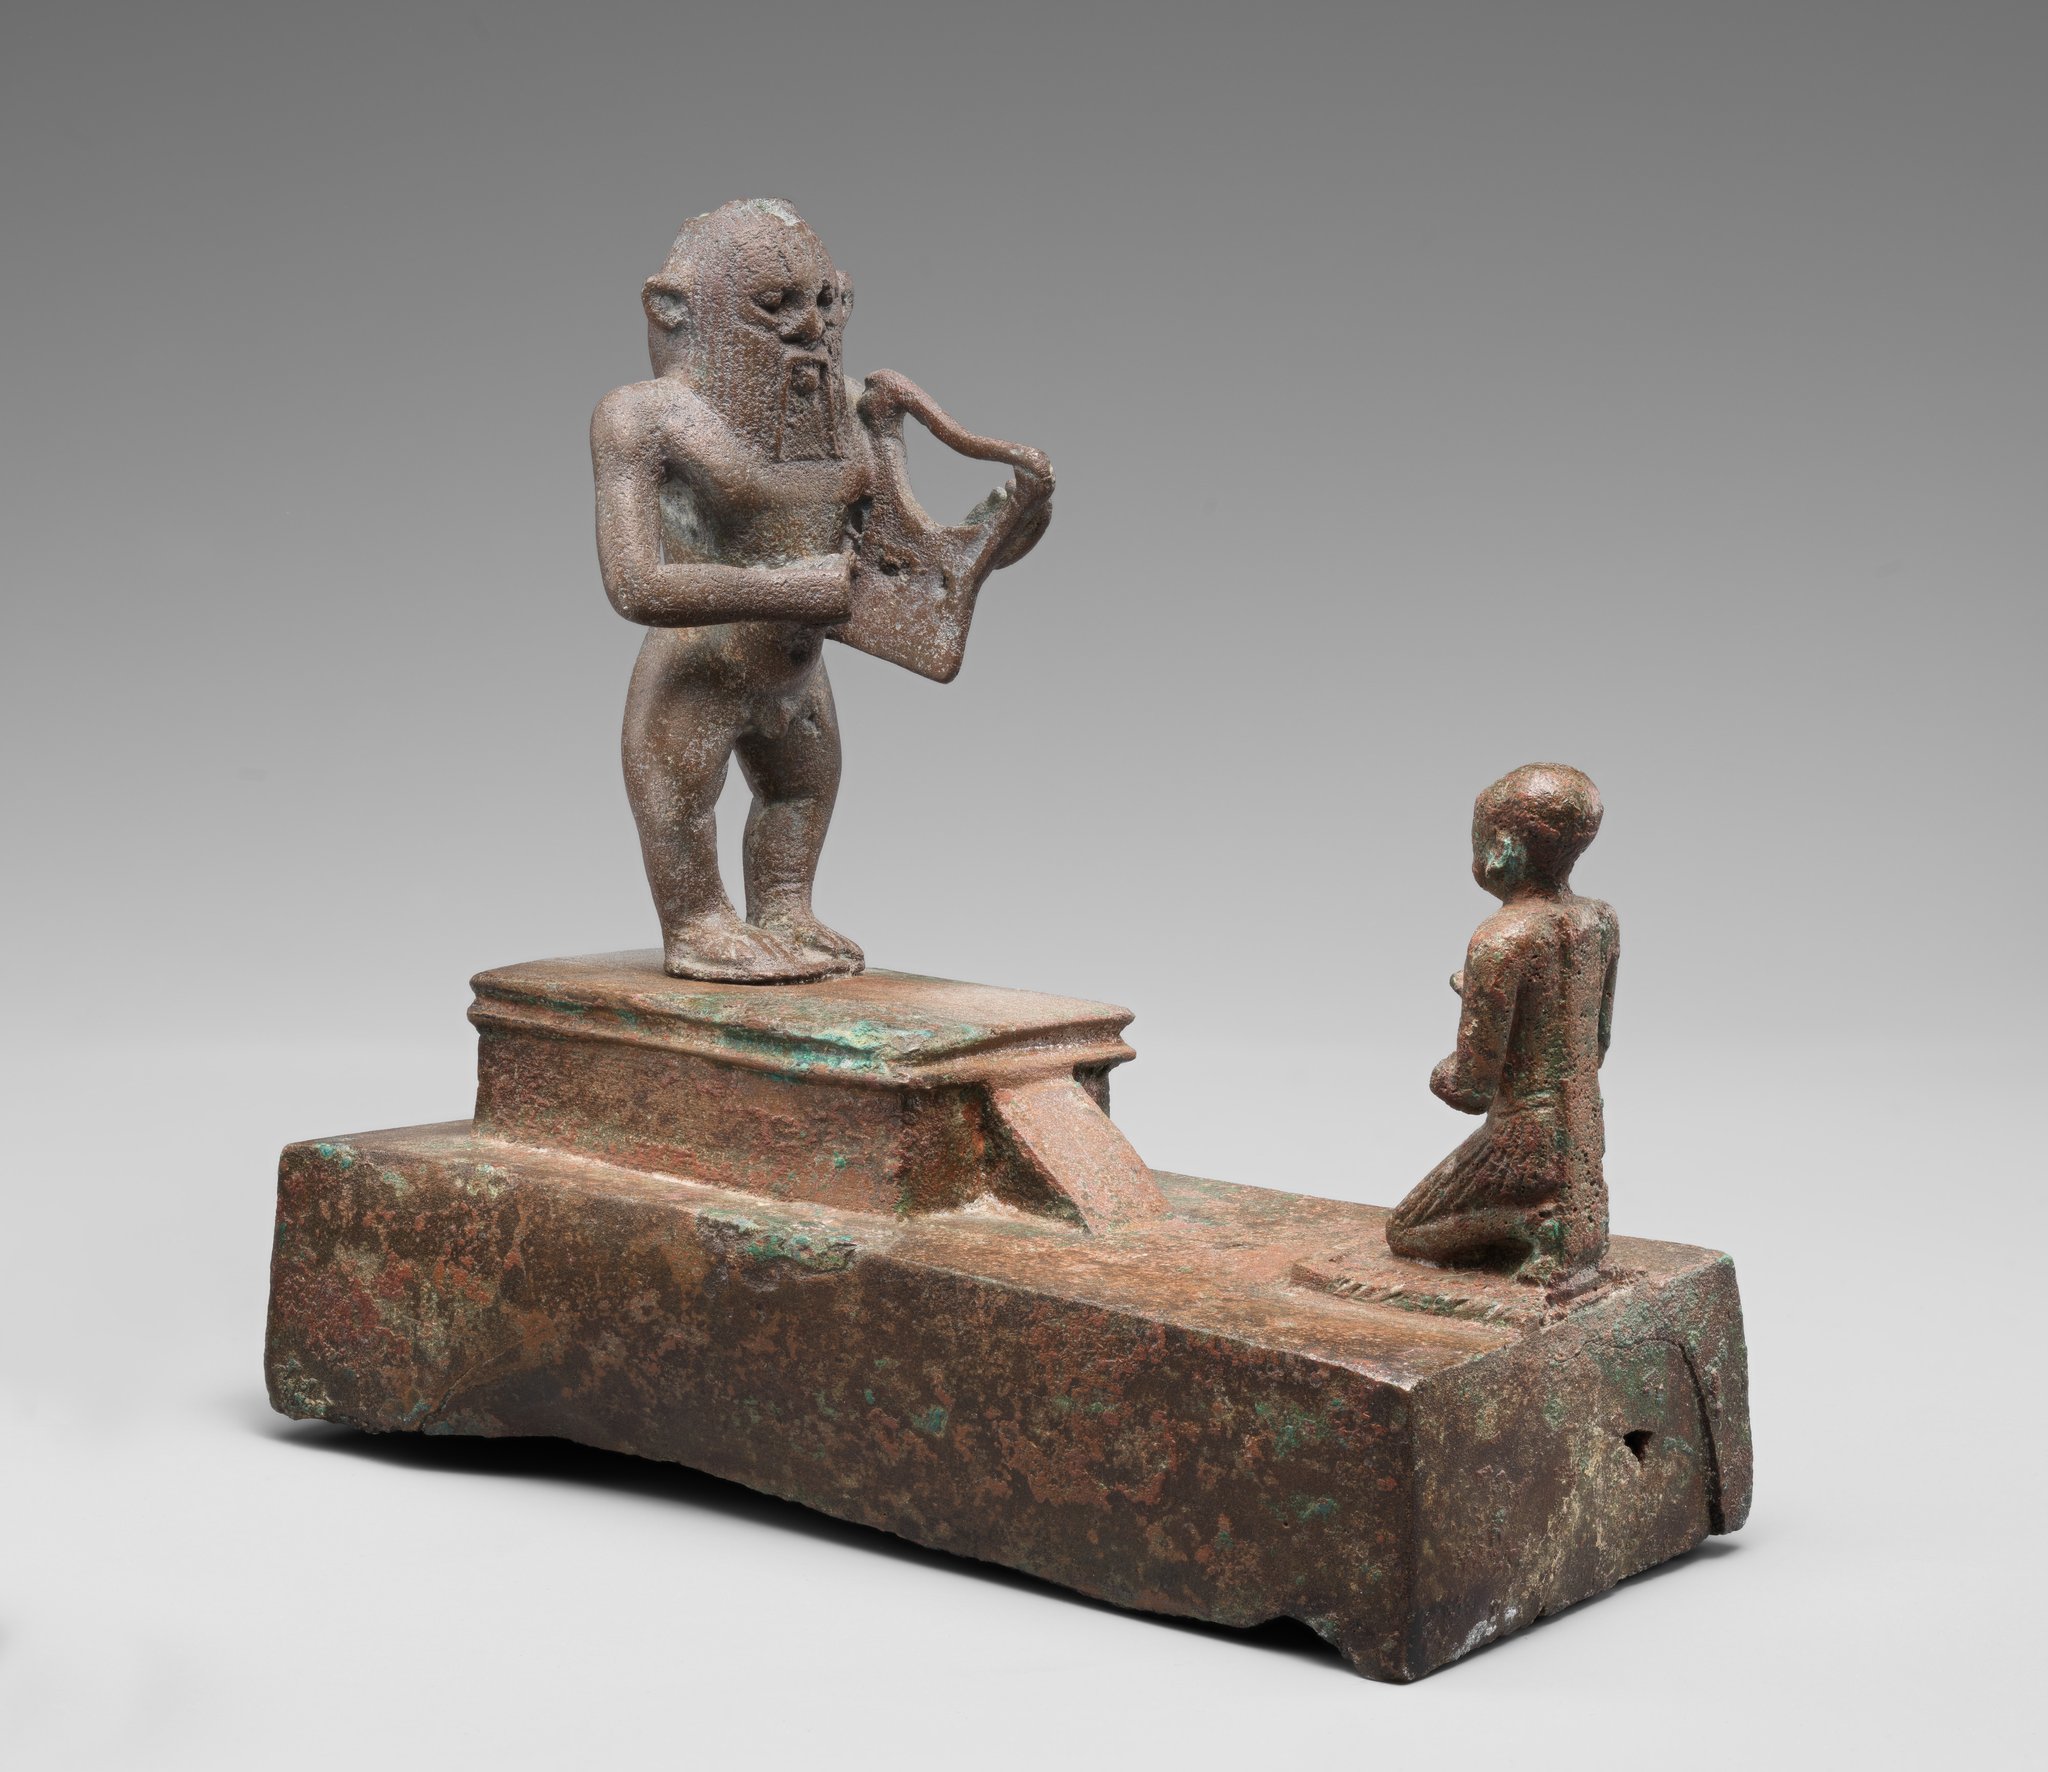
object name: statuette group, be, worshiper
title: Group statue with a Bes-image plucking a lyre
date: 664-630 BCE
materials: metal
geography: egypt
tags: men,bes